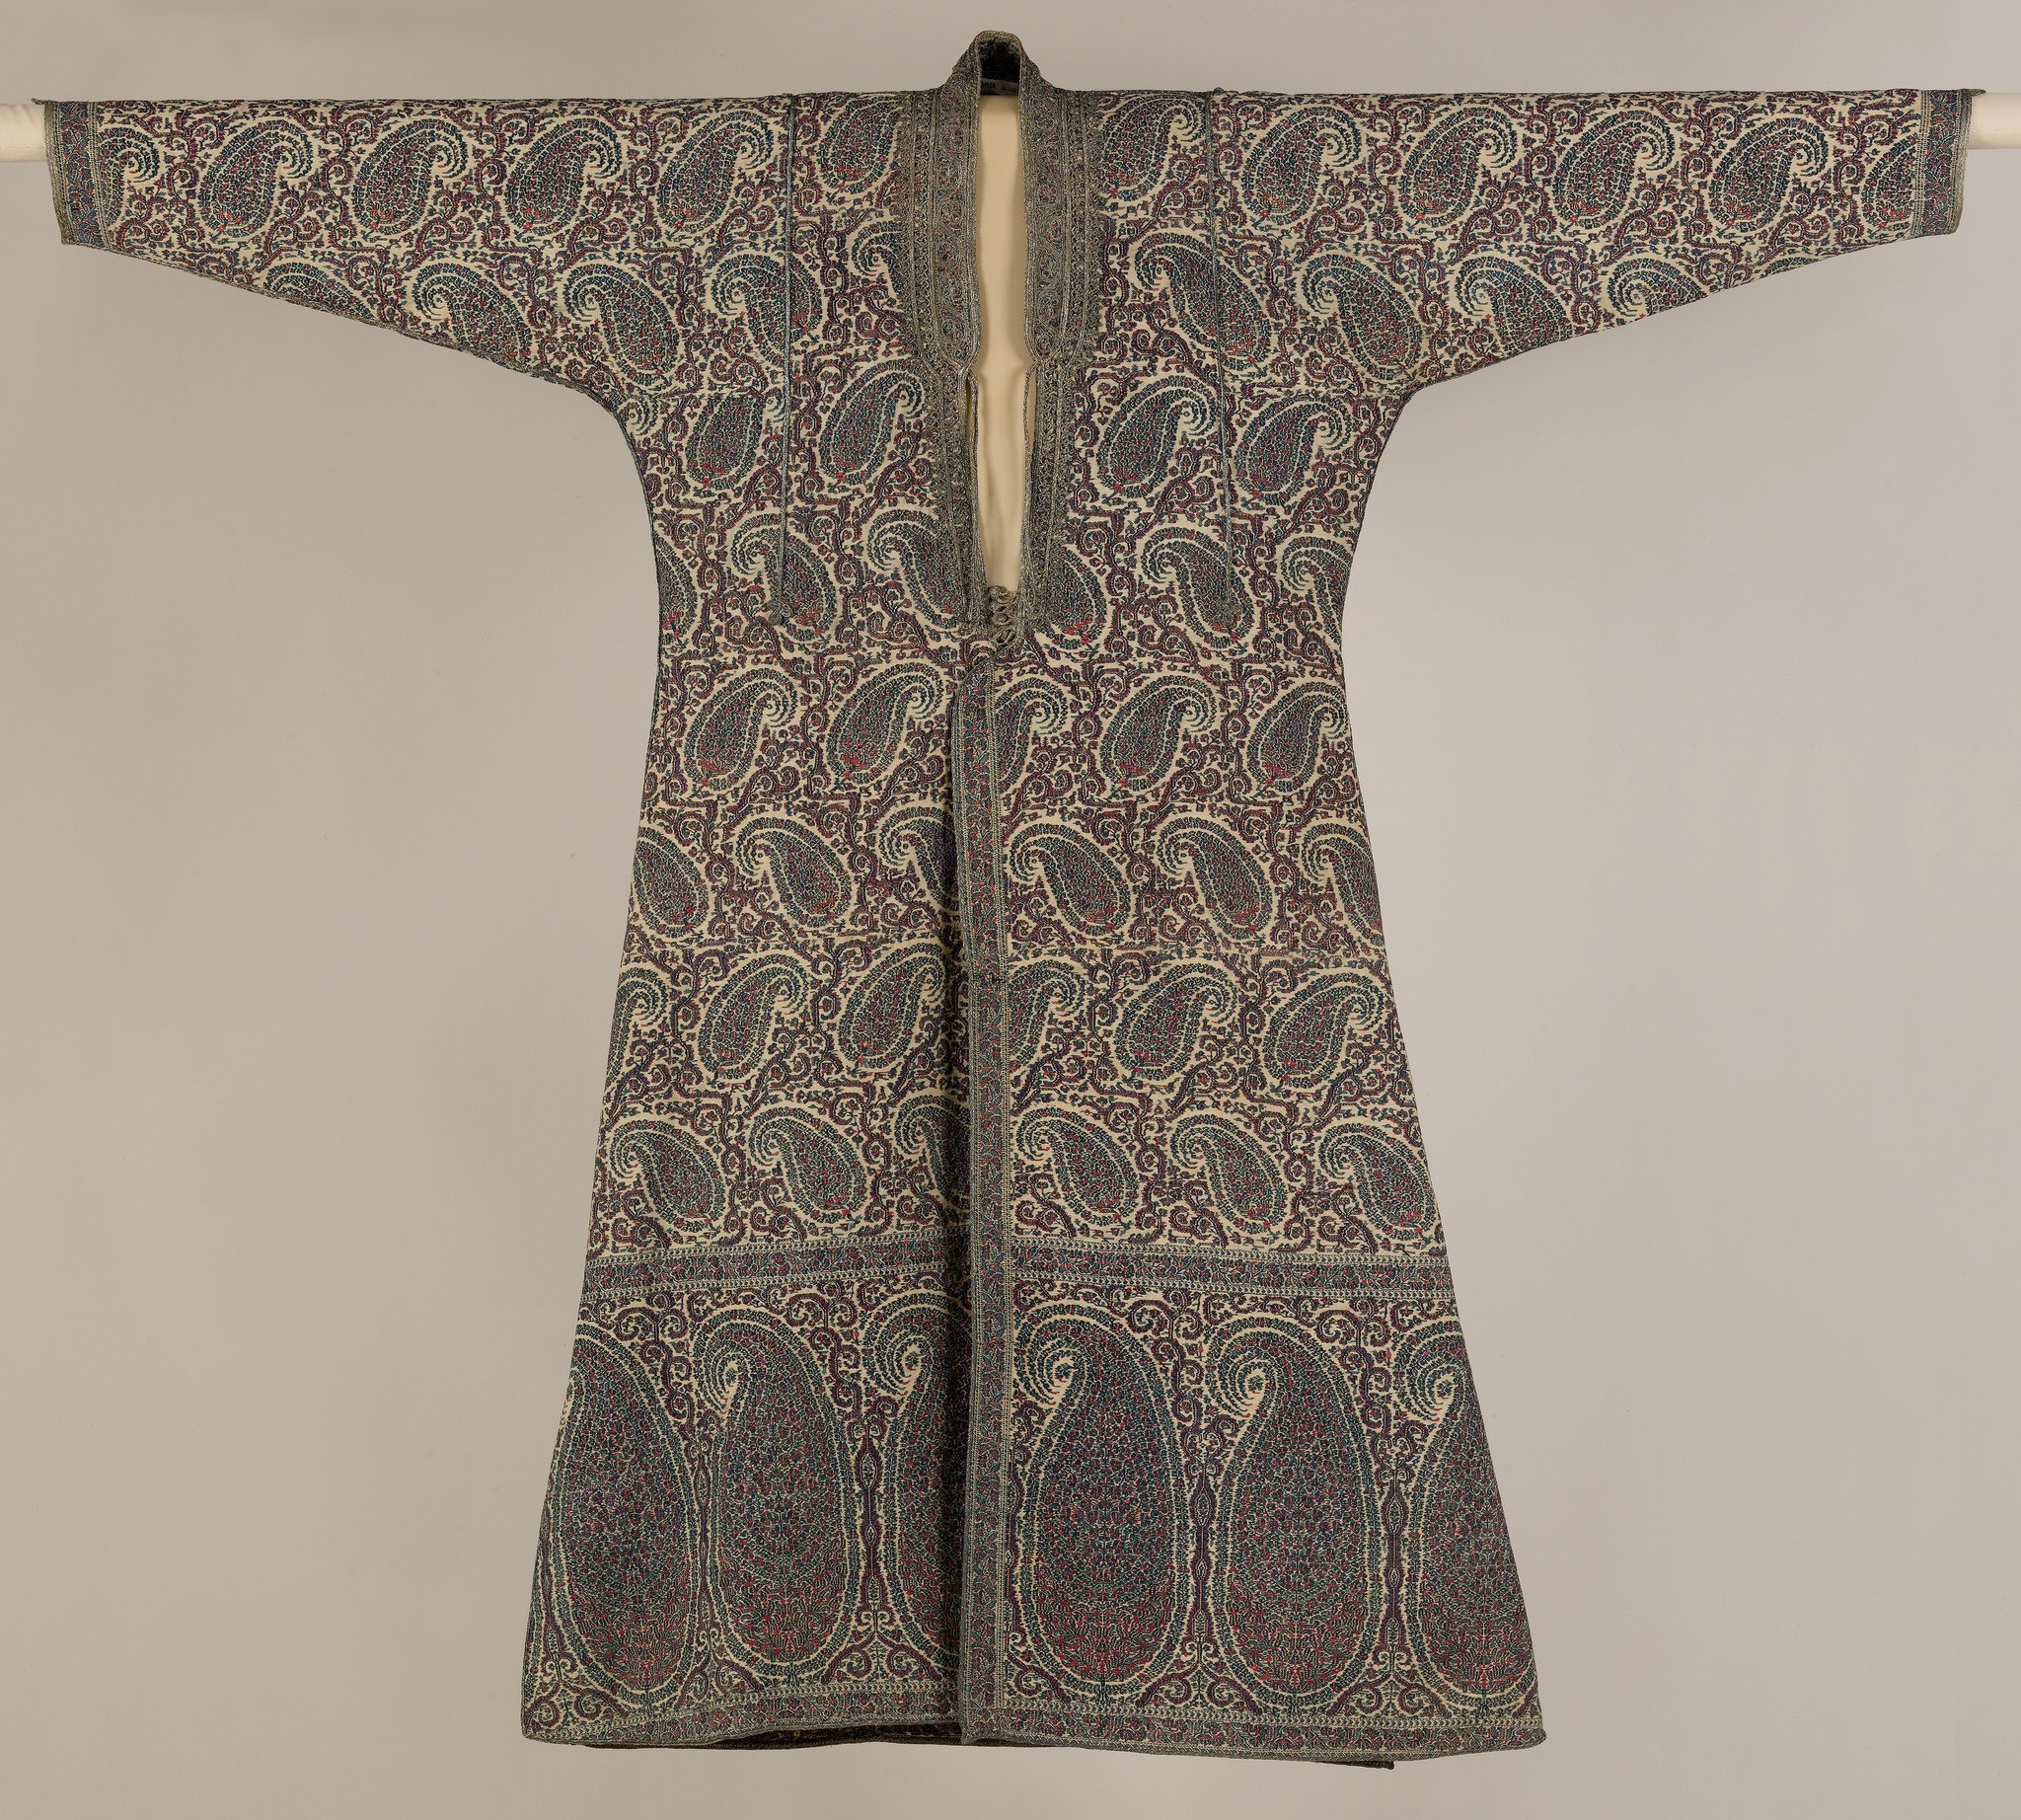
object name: coat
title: Man's Coat (Choga)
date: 1803-1856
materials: metal thread, wool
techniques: interlocking, weave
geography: india